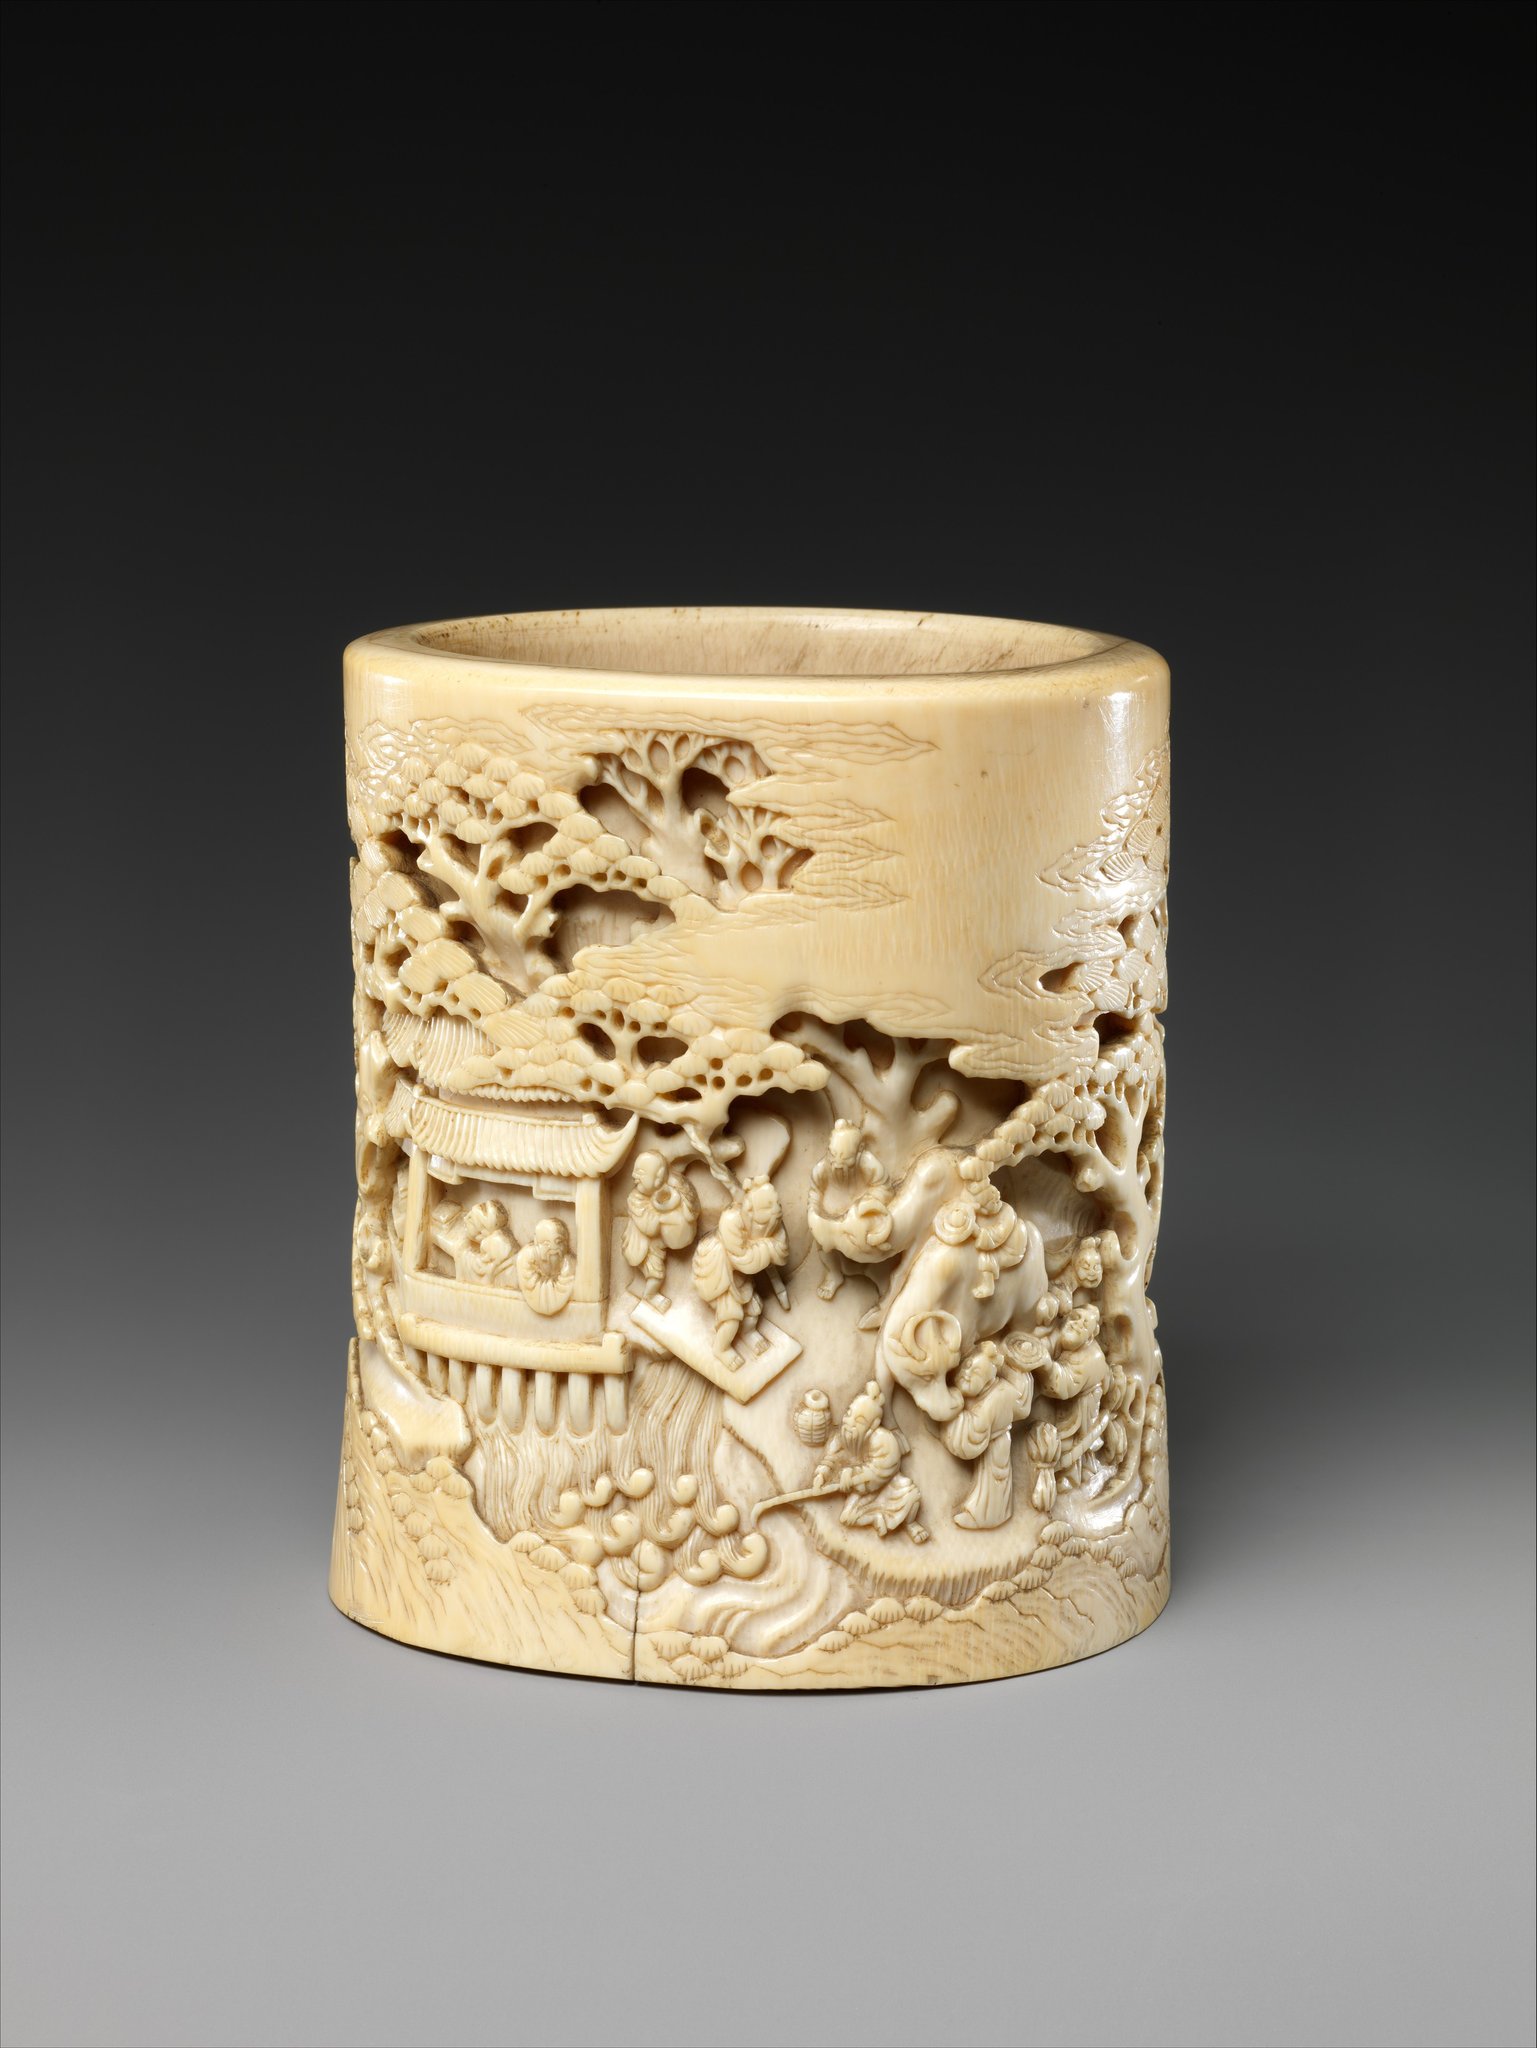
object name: brush holder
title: Brush holder with narrative scene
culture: chinese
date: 1701-1800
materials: ivory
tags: animals,men,fishing,trees